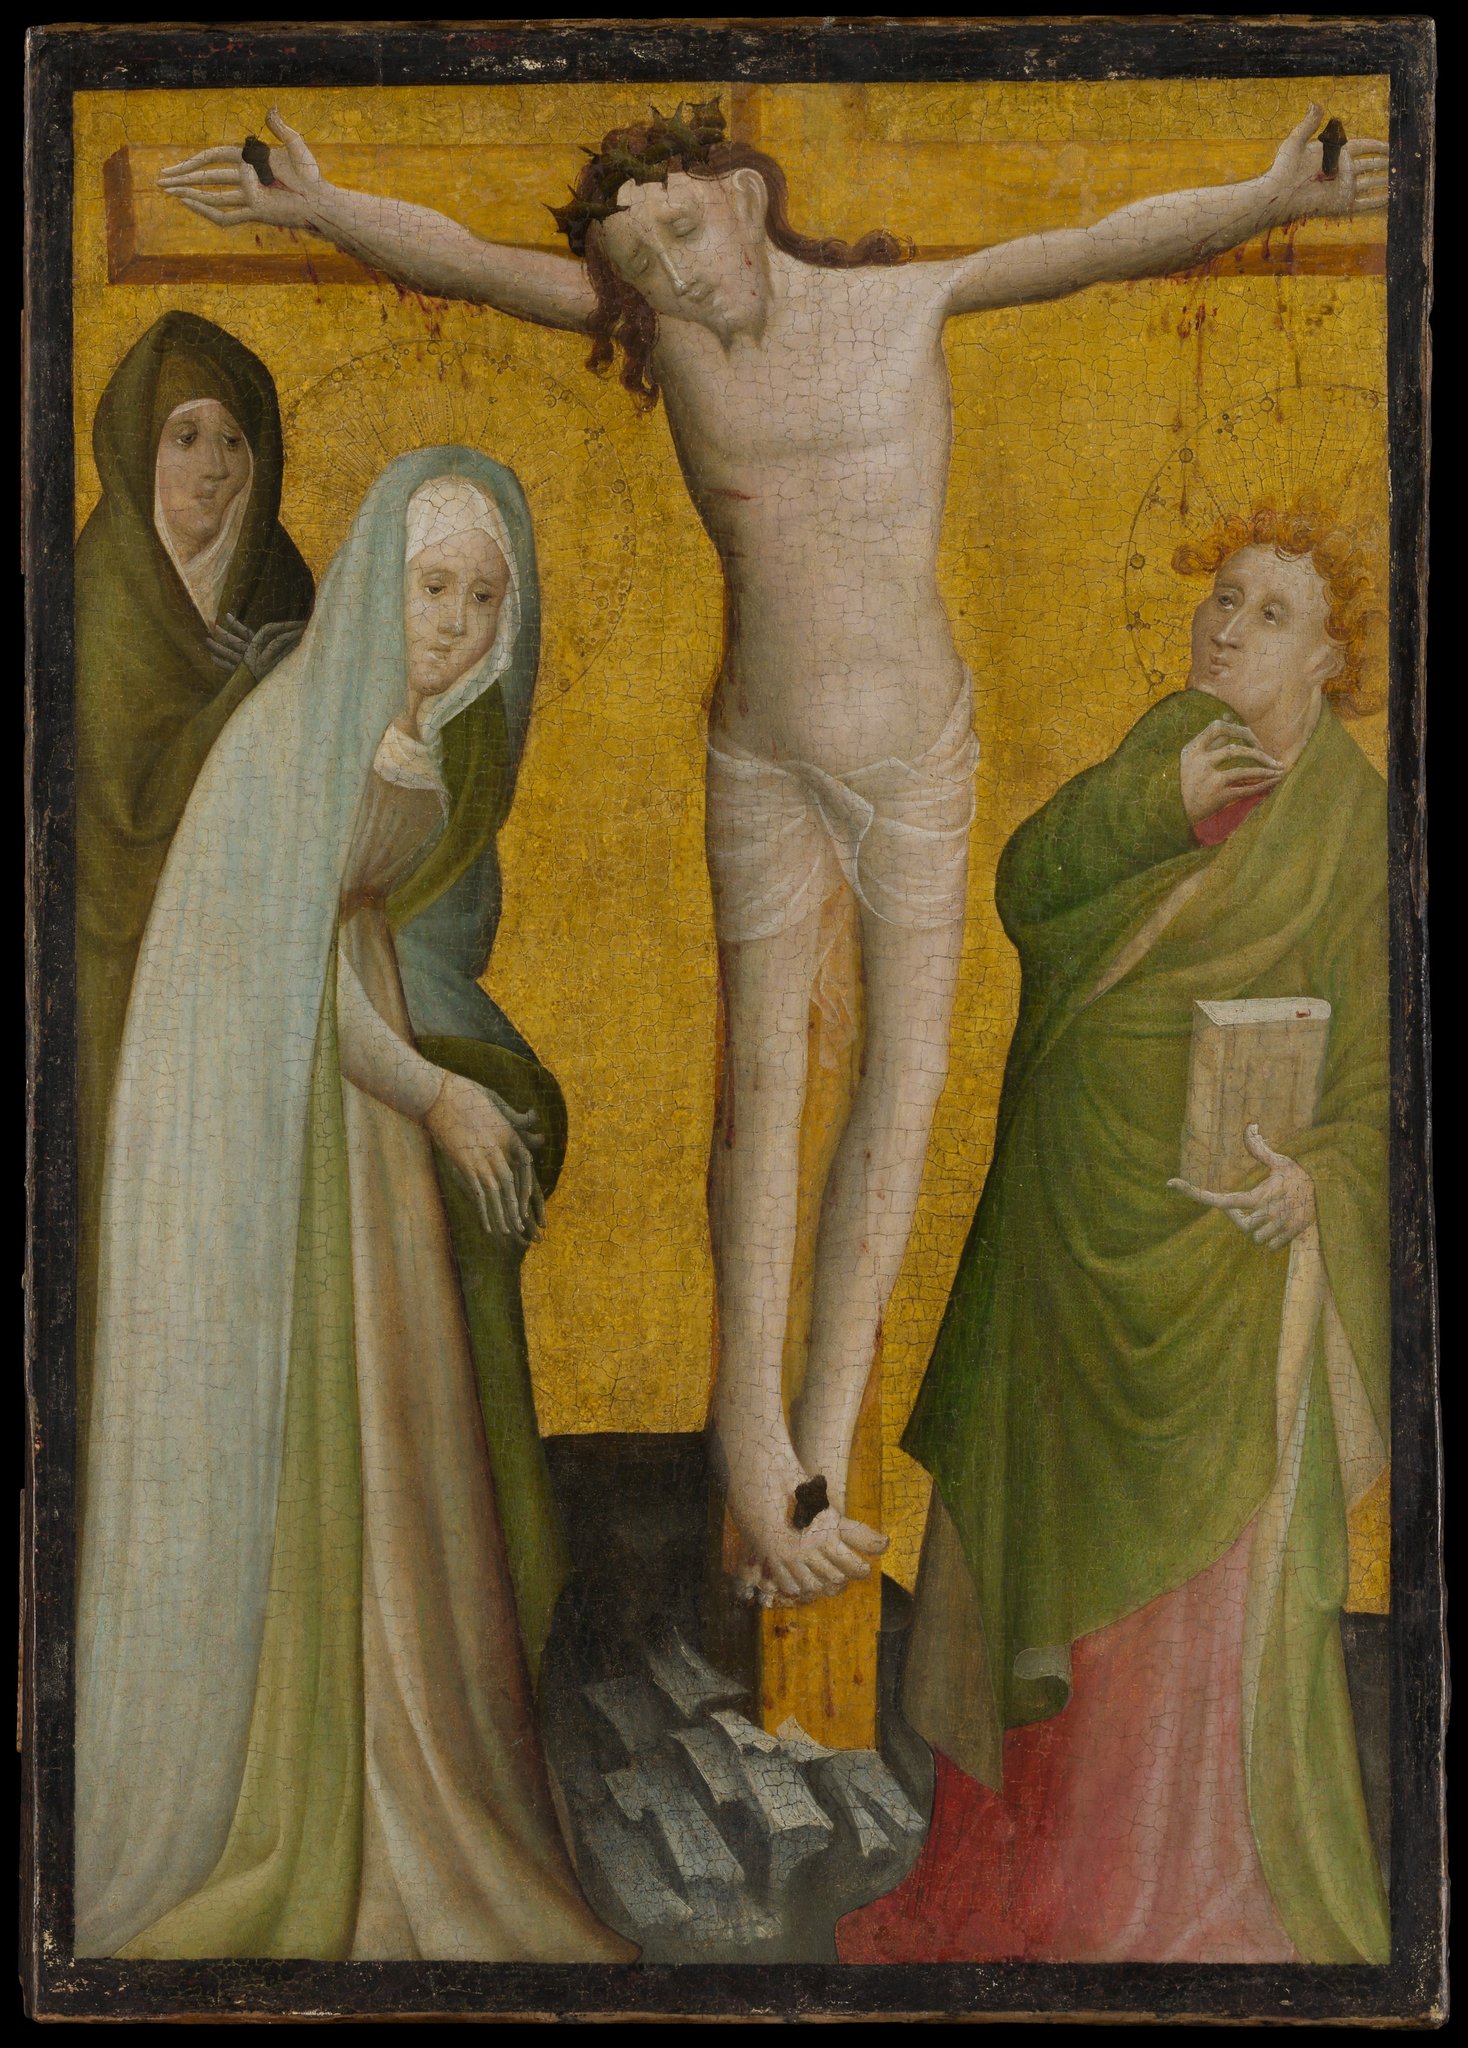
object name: painting, part of the wing of an altarpiece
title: The Crucifixion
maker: master of the berswordt altar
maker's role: artist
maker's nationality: german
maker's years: 1400-1435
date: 1400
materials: gold, oil, wood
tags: women,christ,mary magdalene,saint john the evangelist,virgin mary,crucifixion